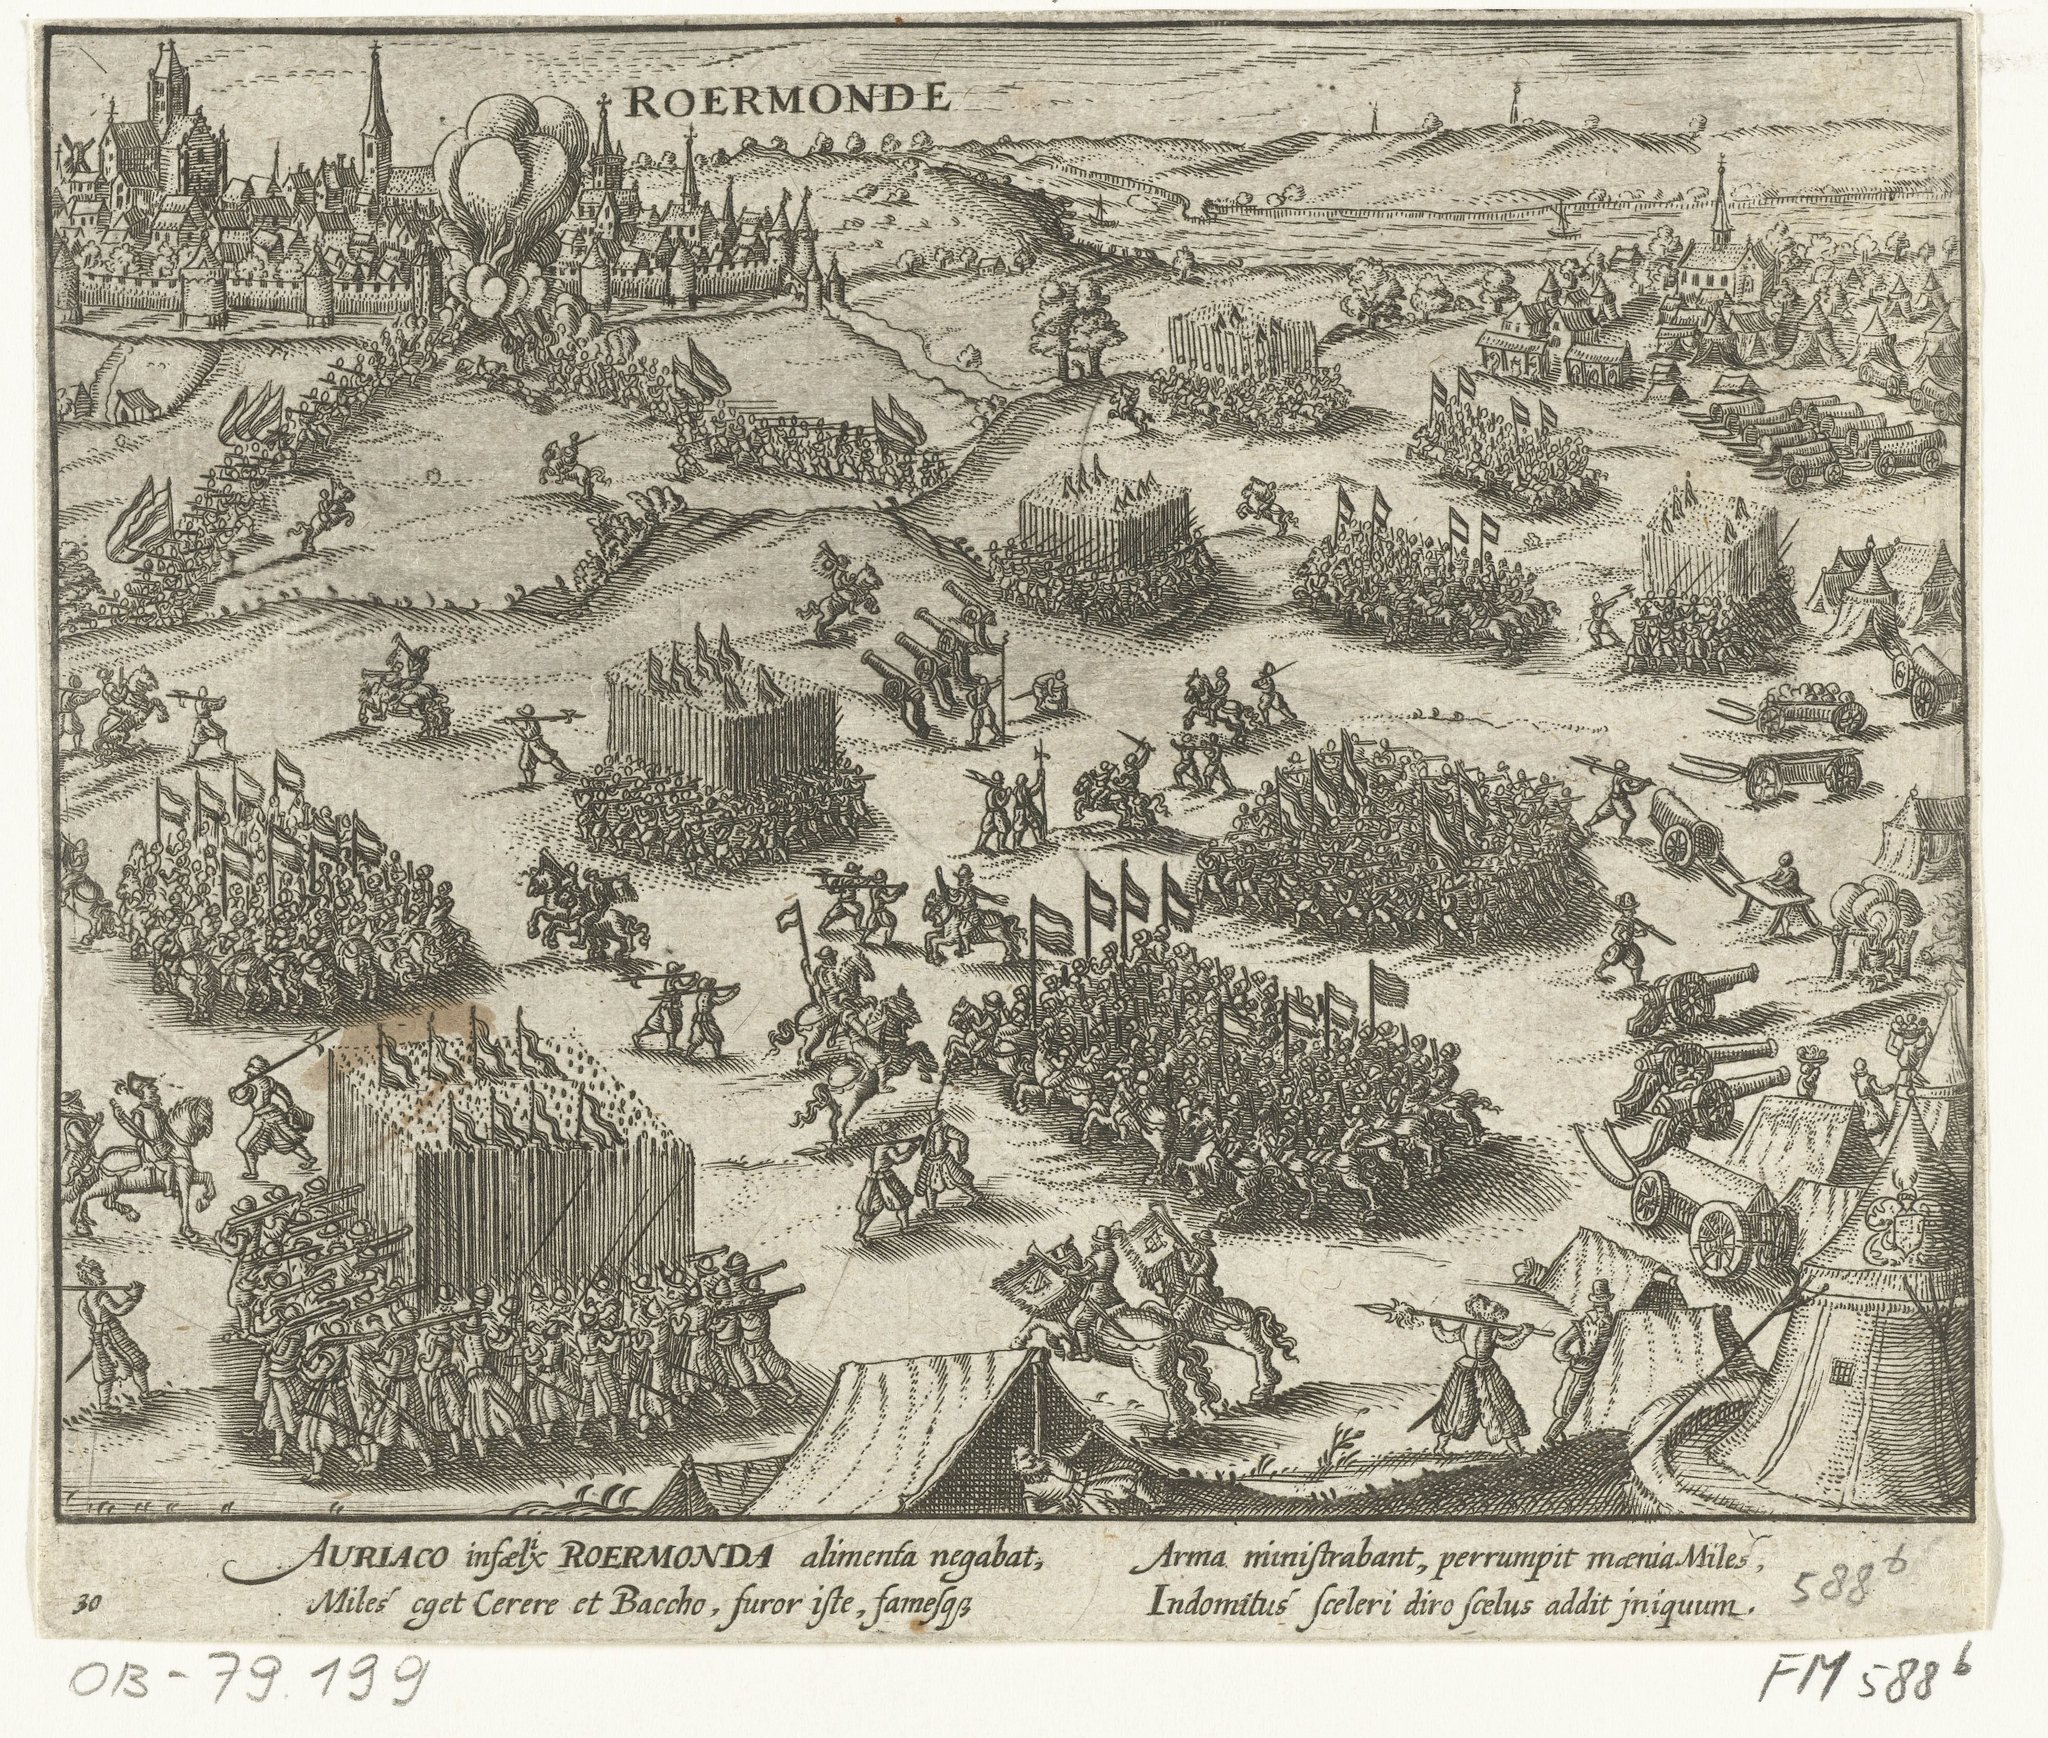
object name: print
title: Roermond door Willem van Oranje ingenomen, 1572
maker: Anonymous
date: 1613-1615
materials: paper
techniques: etching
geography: germany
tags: delft, william i (prince of orange), capture of city (after the siege)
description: Roermond door Willem van Oranje ingenomen, 1572, 4 augustus 1572. Op de voorgrond het kampement van het leger van de prins, boven trekt het leger de stad binnen. Met onderschrift van 4 regels in het Latijn. Genummerd: 30. Onbedrukt op de achterzijde.